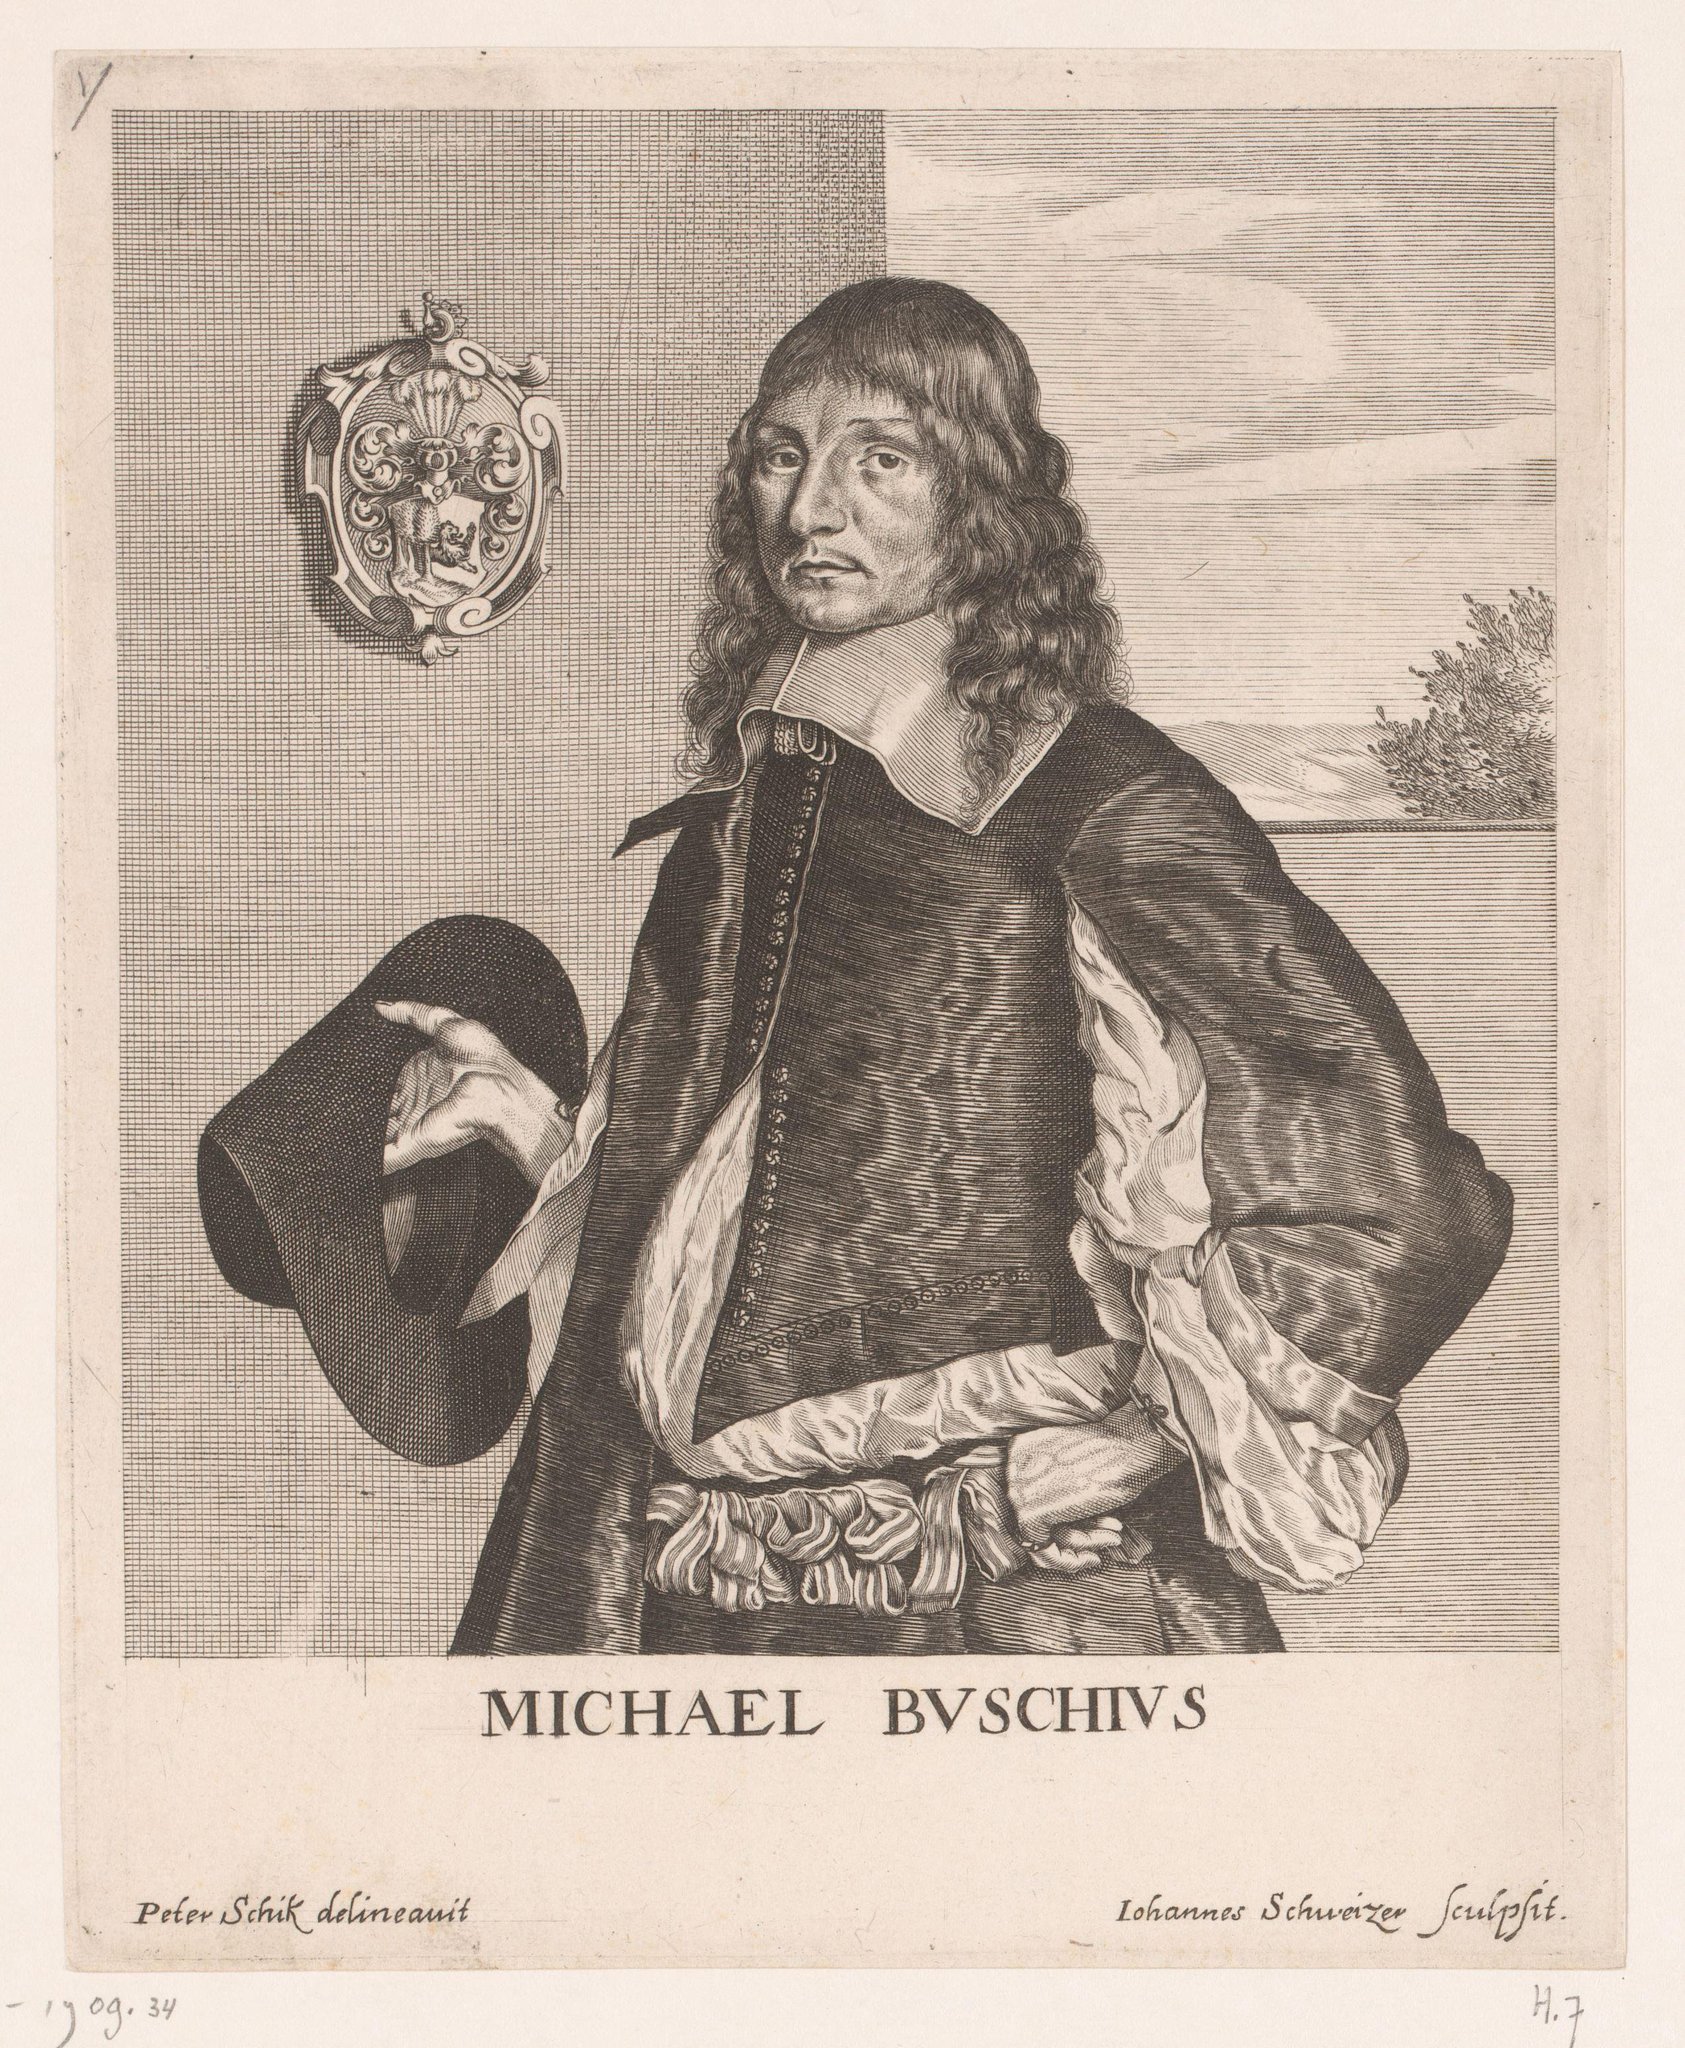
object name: print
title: Portret van Michael Busch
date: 1635-1670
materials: paper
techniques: engraving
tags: historical persons, armorial bearing, heraldry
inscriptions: collector's mark: Lugt 2228